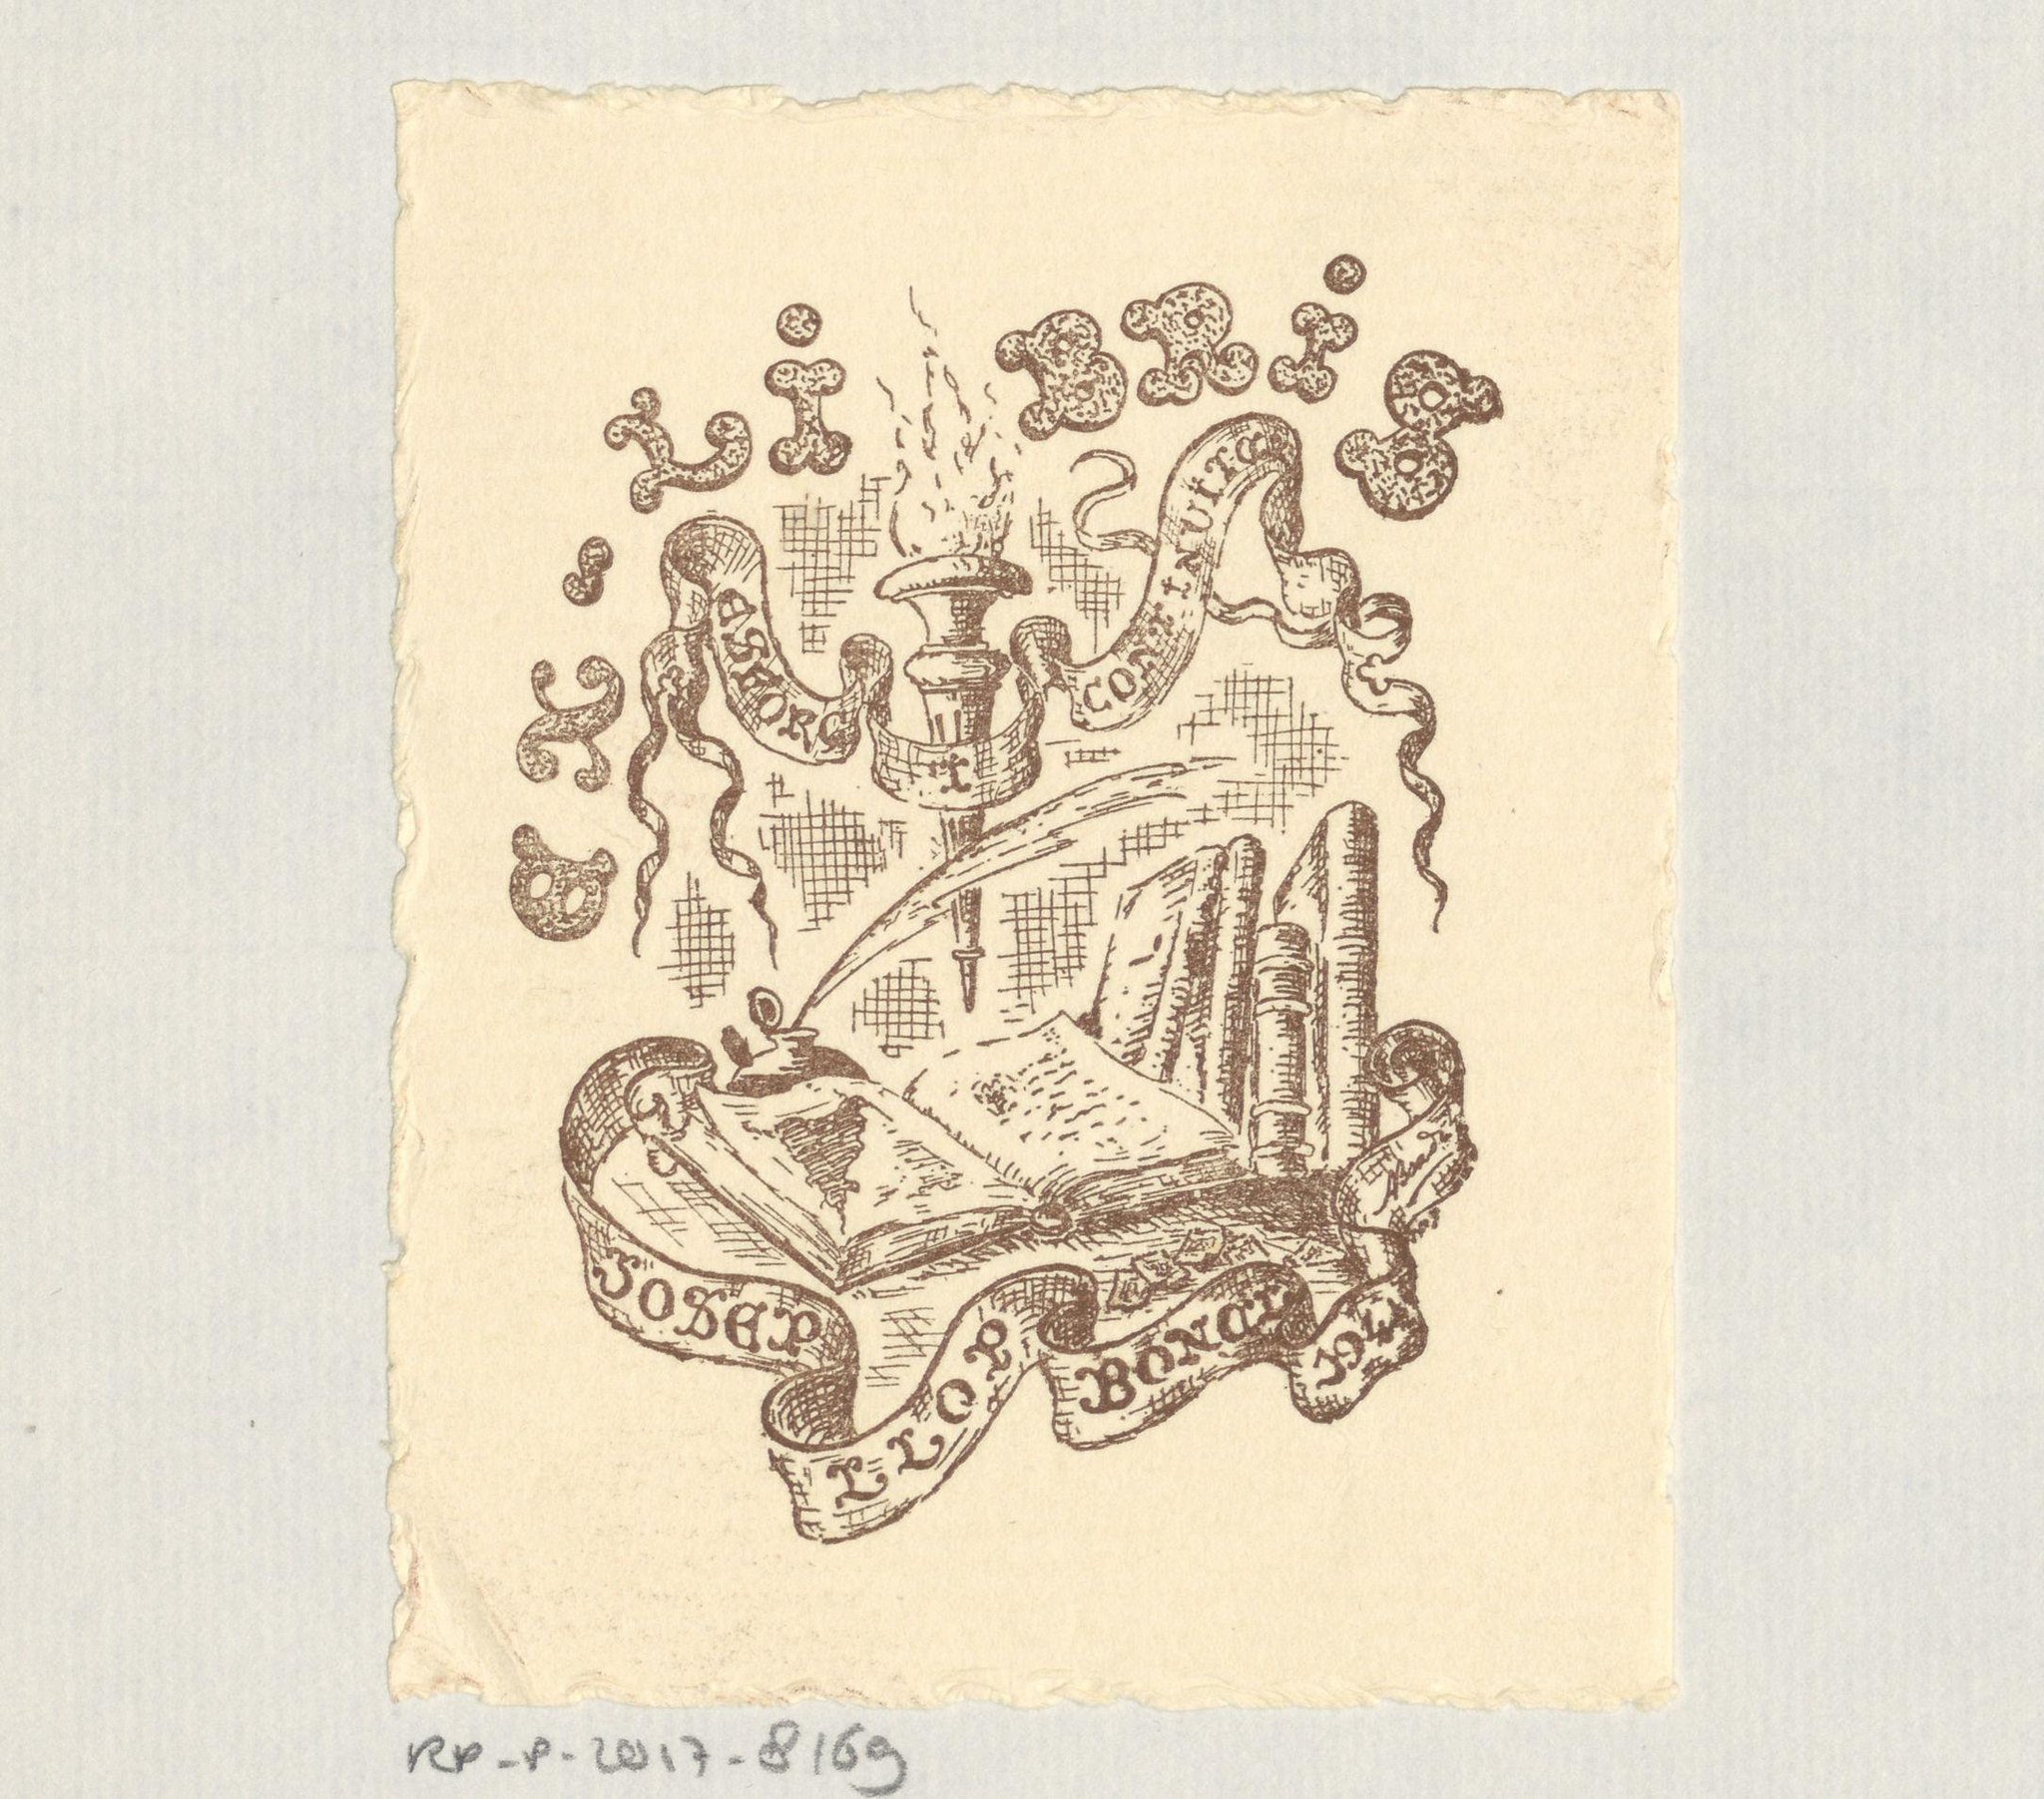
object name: bookplate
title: Esforg i continuïtat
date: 1944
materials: paper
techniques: printing block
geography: spain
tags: publisher, josep llop i bonal, torch, book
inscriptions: workshop stamp: ‘Llop/ Ssera 5-1/ Masnou’